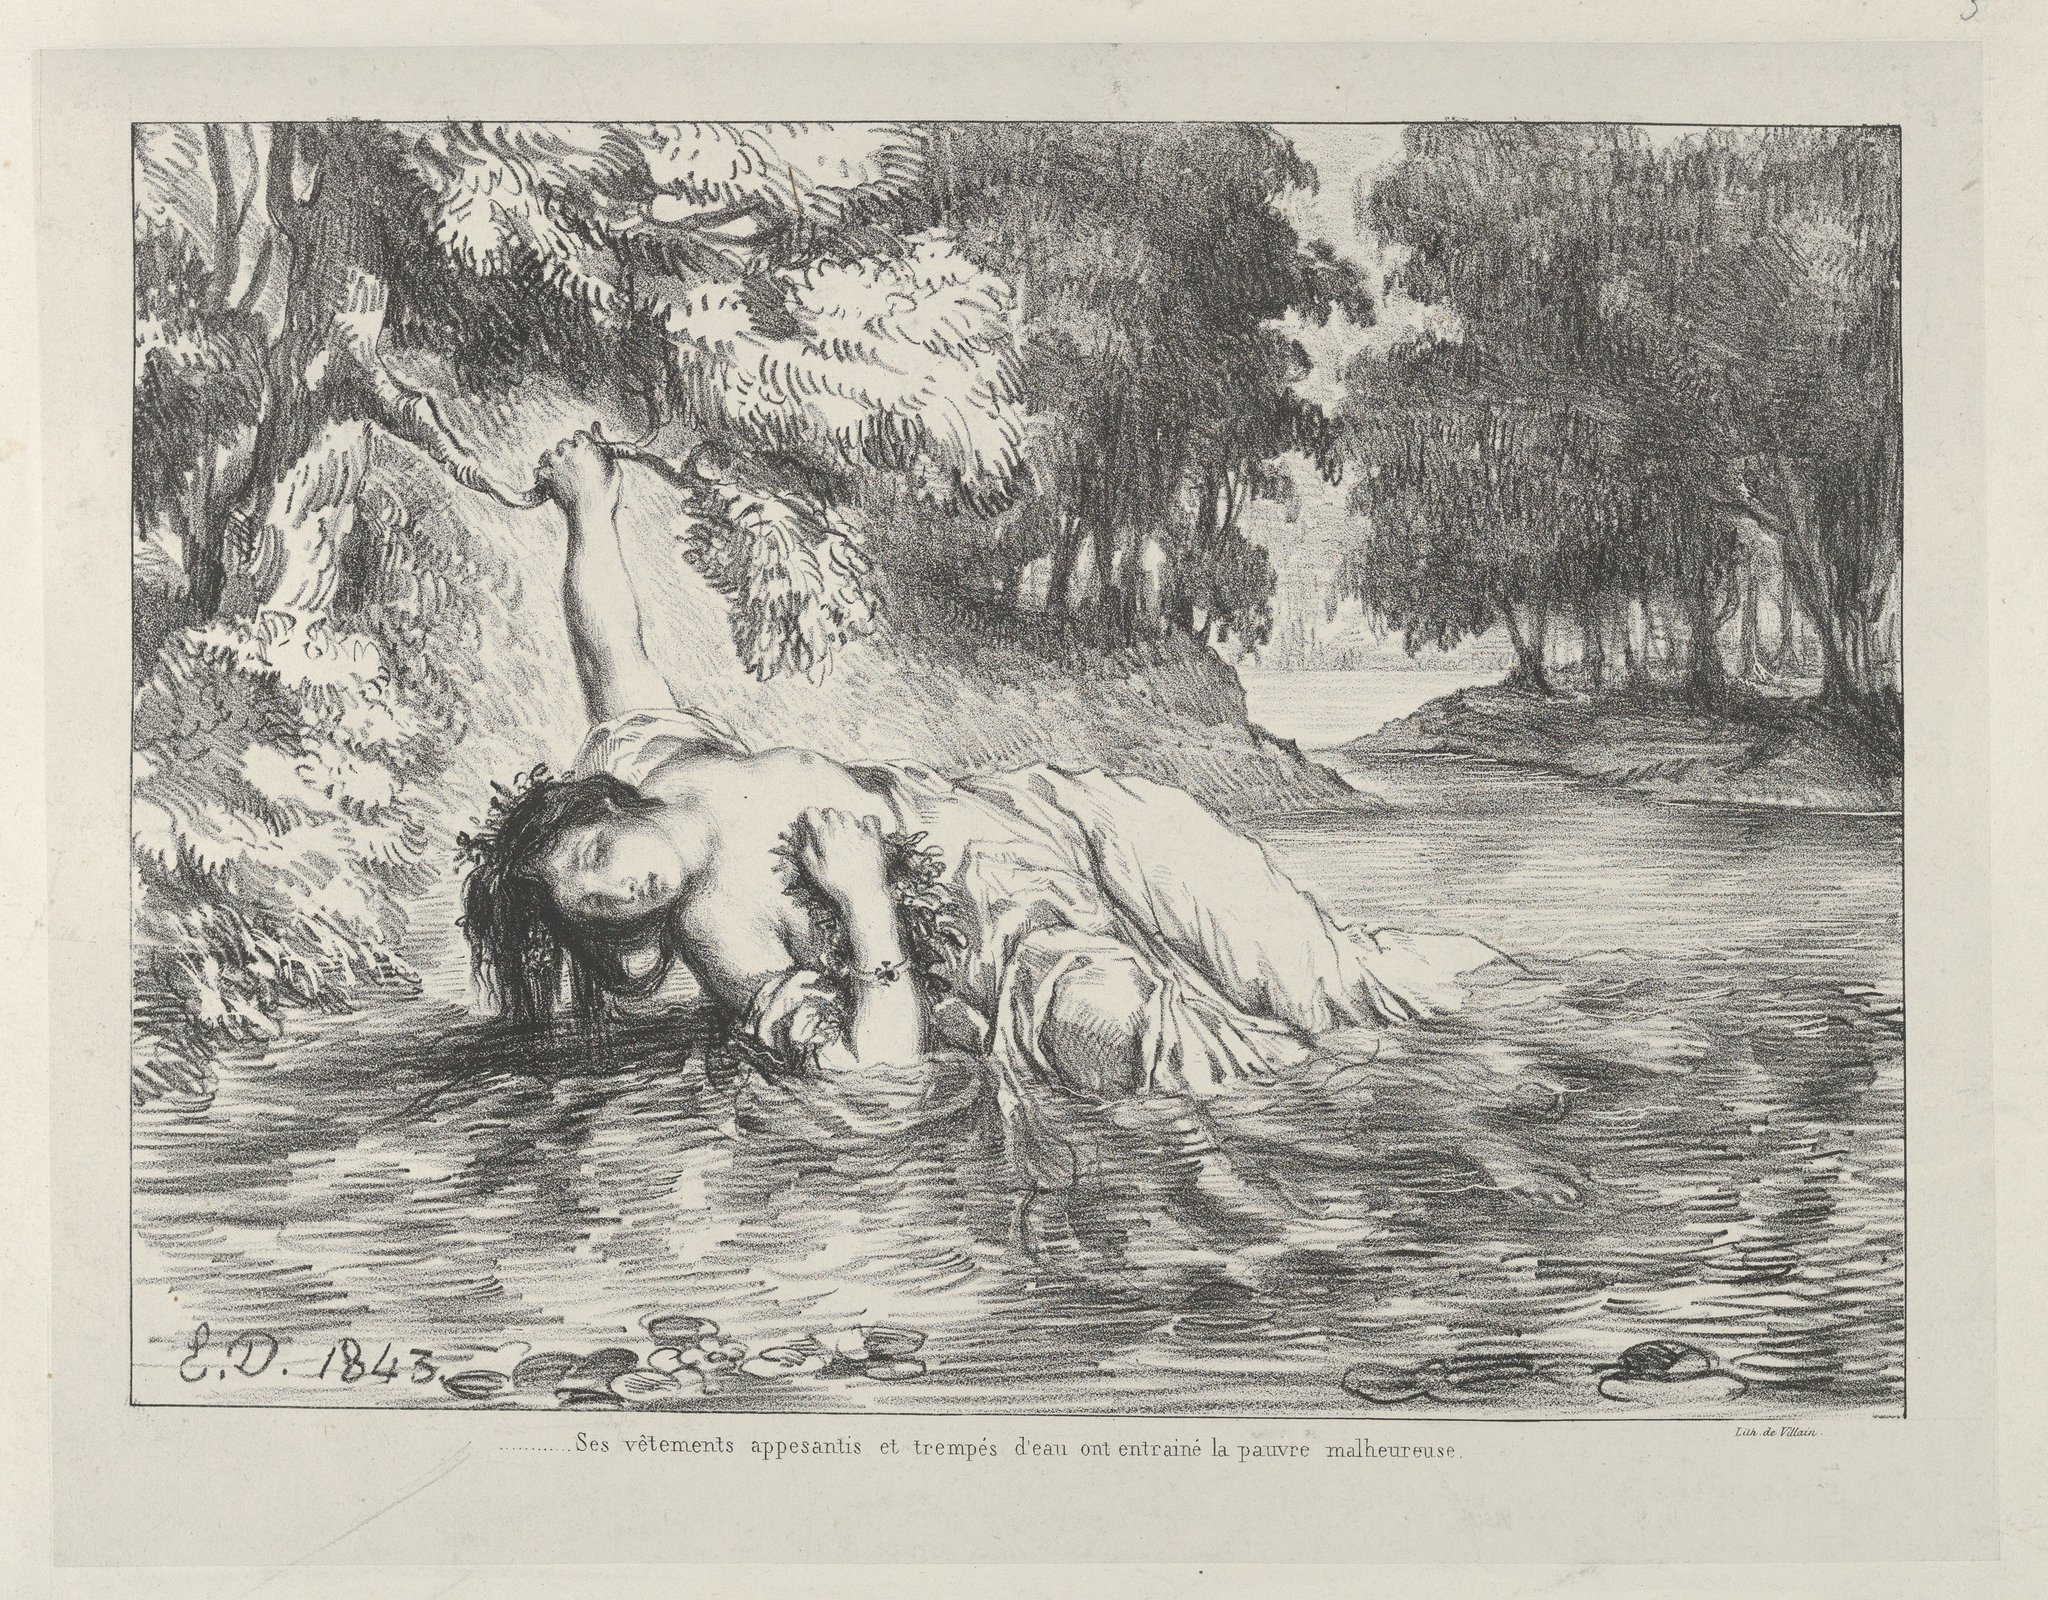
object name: print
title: The Death of Ophelia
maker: eugène delacroix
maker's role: artist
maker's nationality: french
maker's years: 1798-1863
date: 1843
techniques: lithograph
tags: shakespeare,women,rivers,death,hamlet